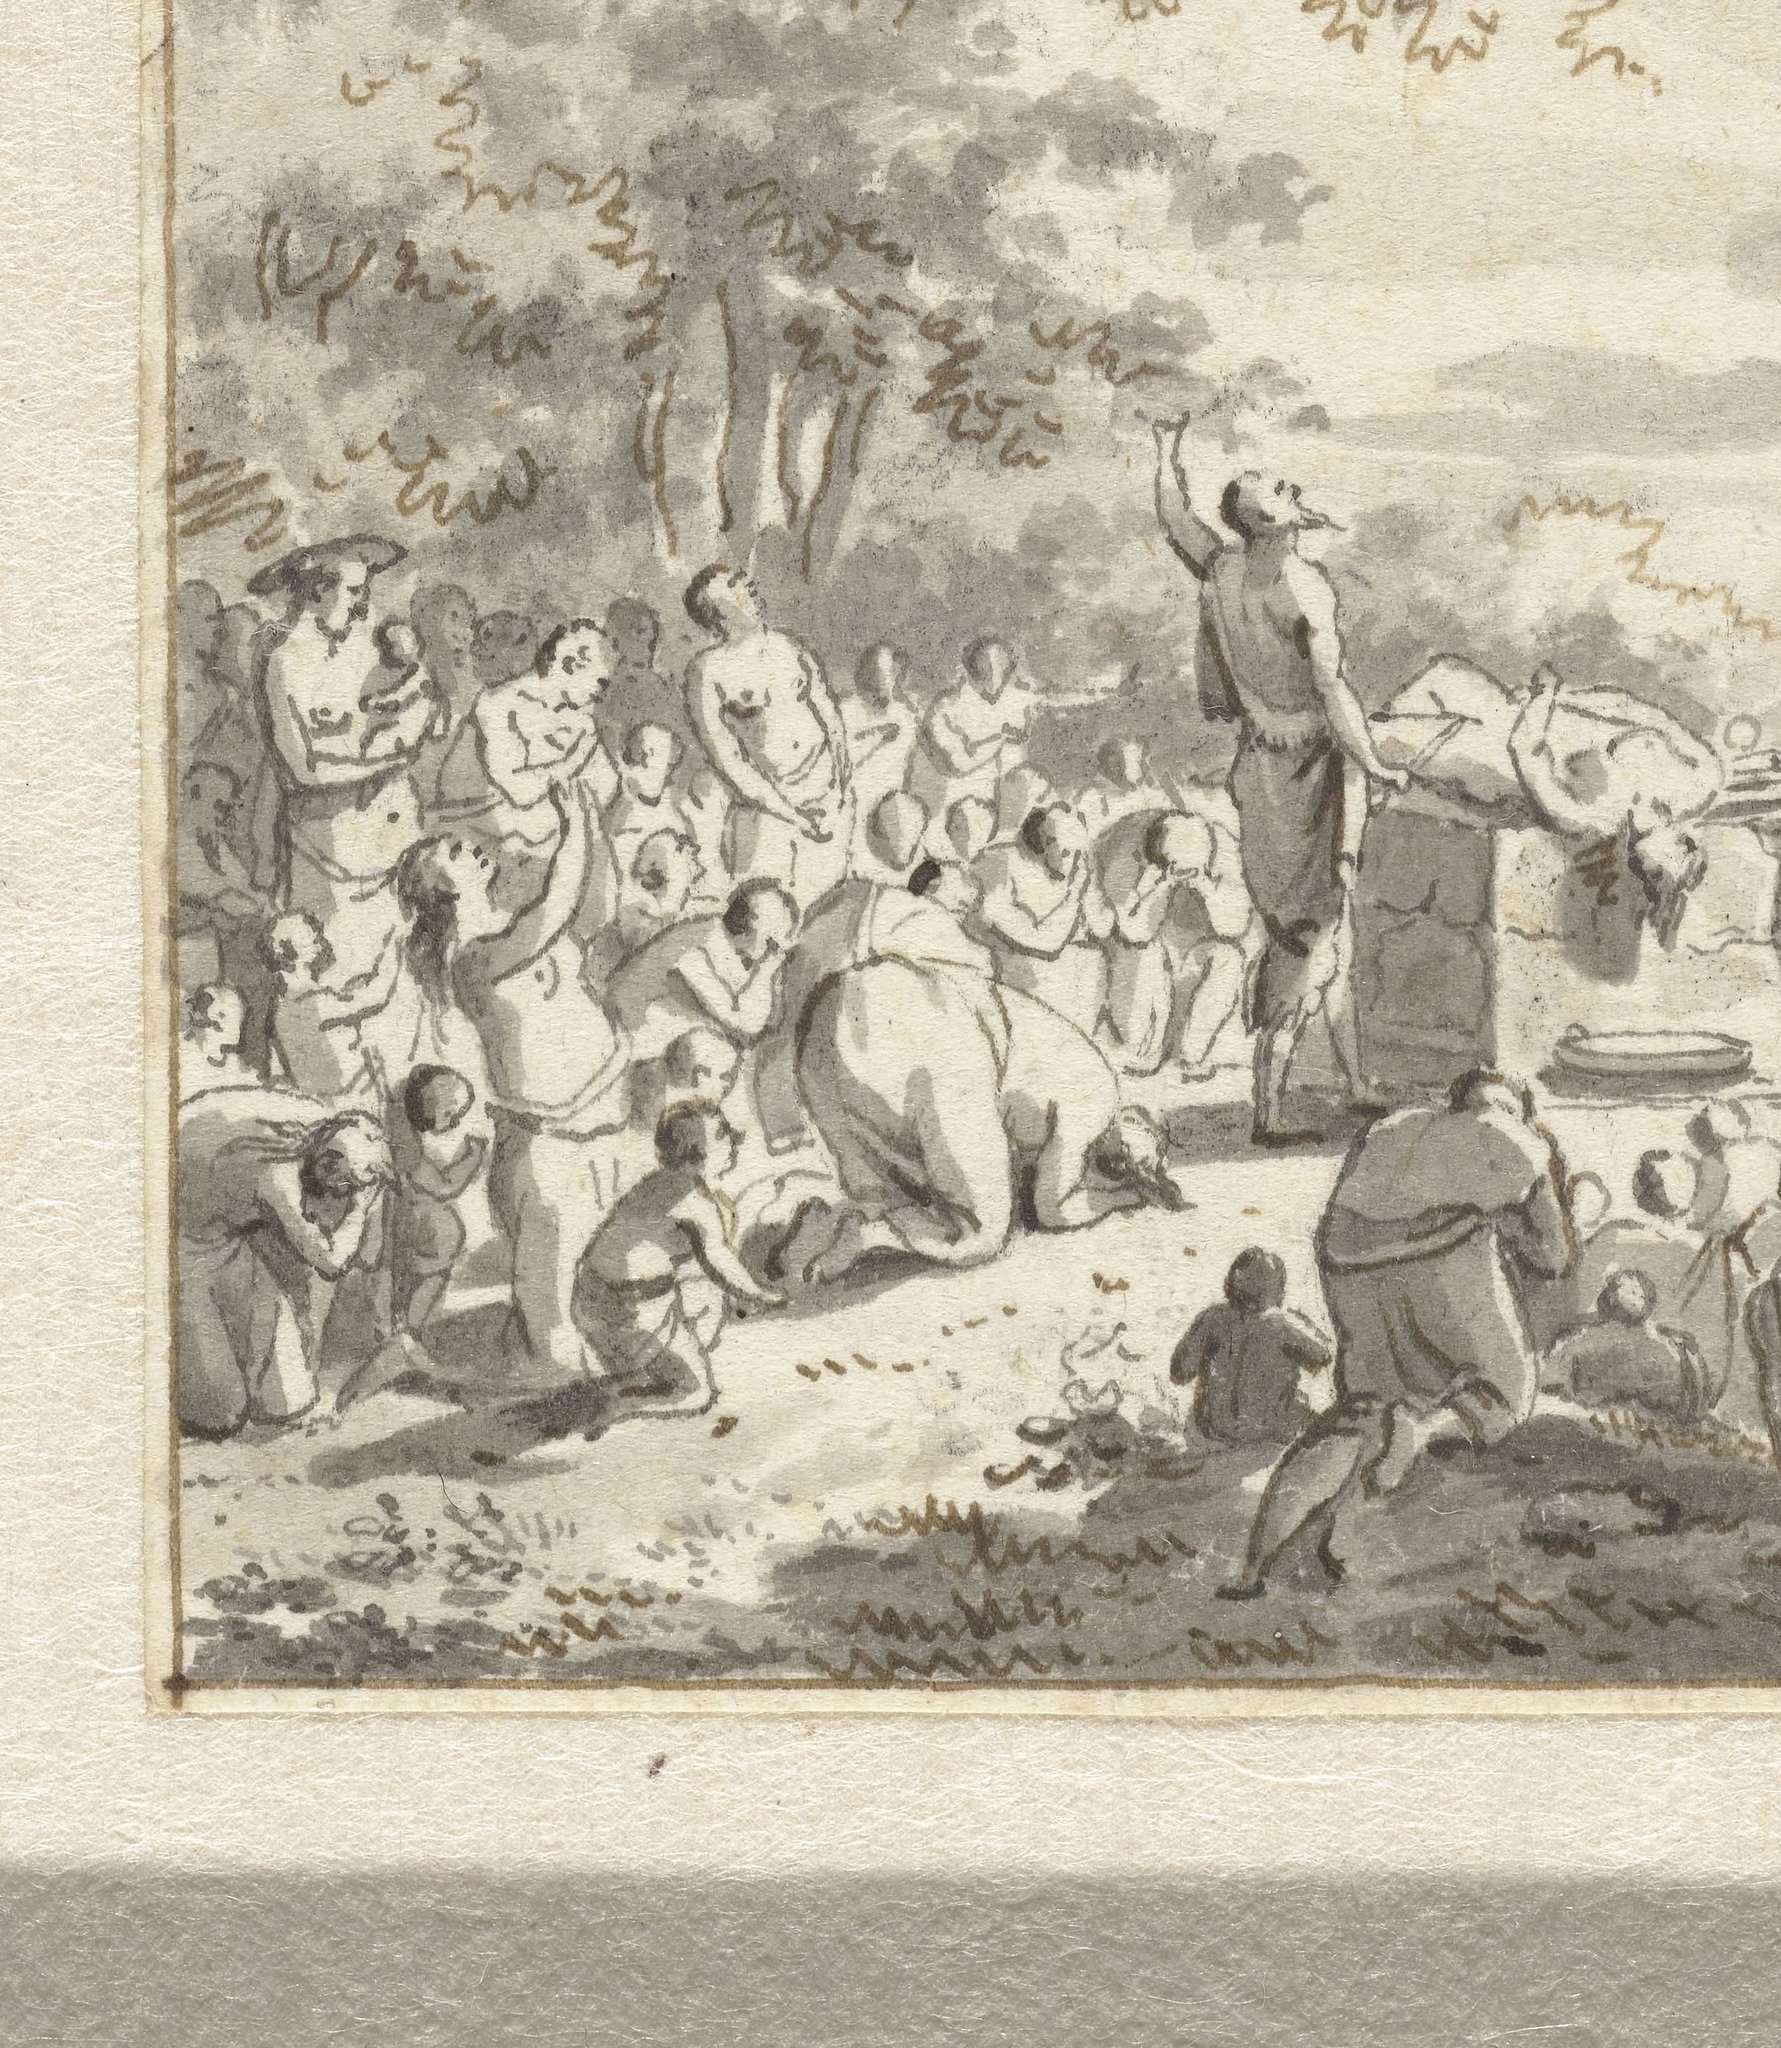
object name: design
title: In de vroegste tyden der Batavieren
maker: Anonymous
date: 1789-1810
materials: ink, paper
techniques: brush, pen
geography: netherlands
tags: extinct, 'historical' peoples (with name), human sacrifice ~ non-christian religions